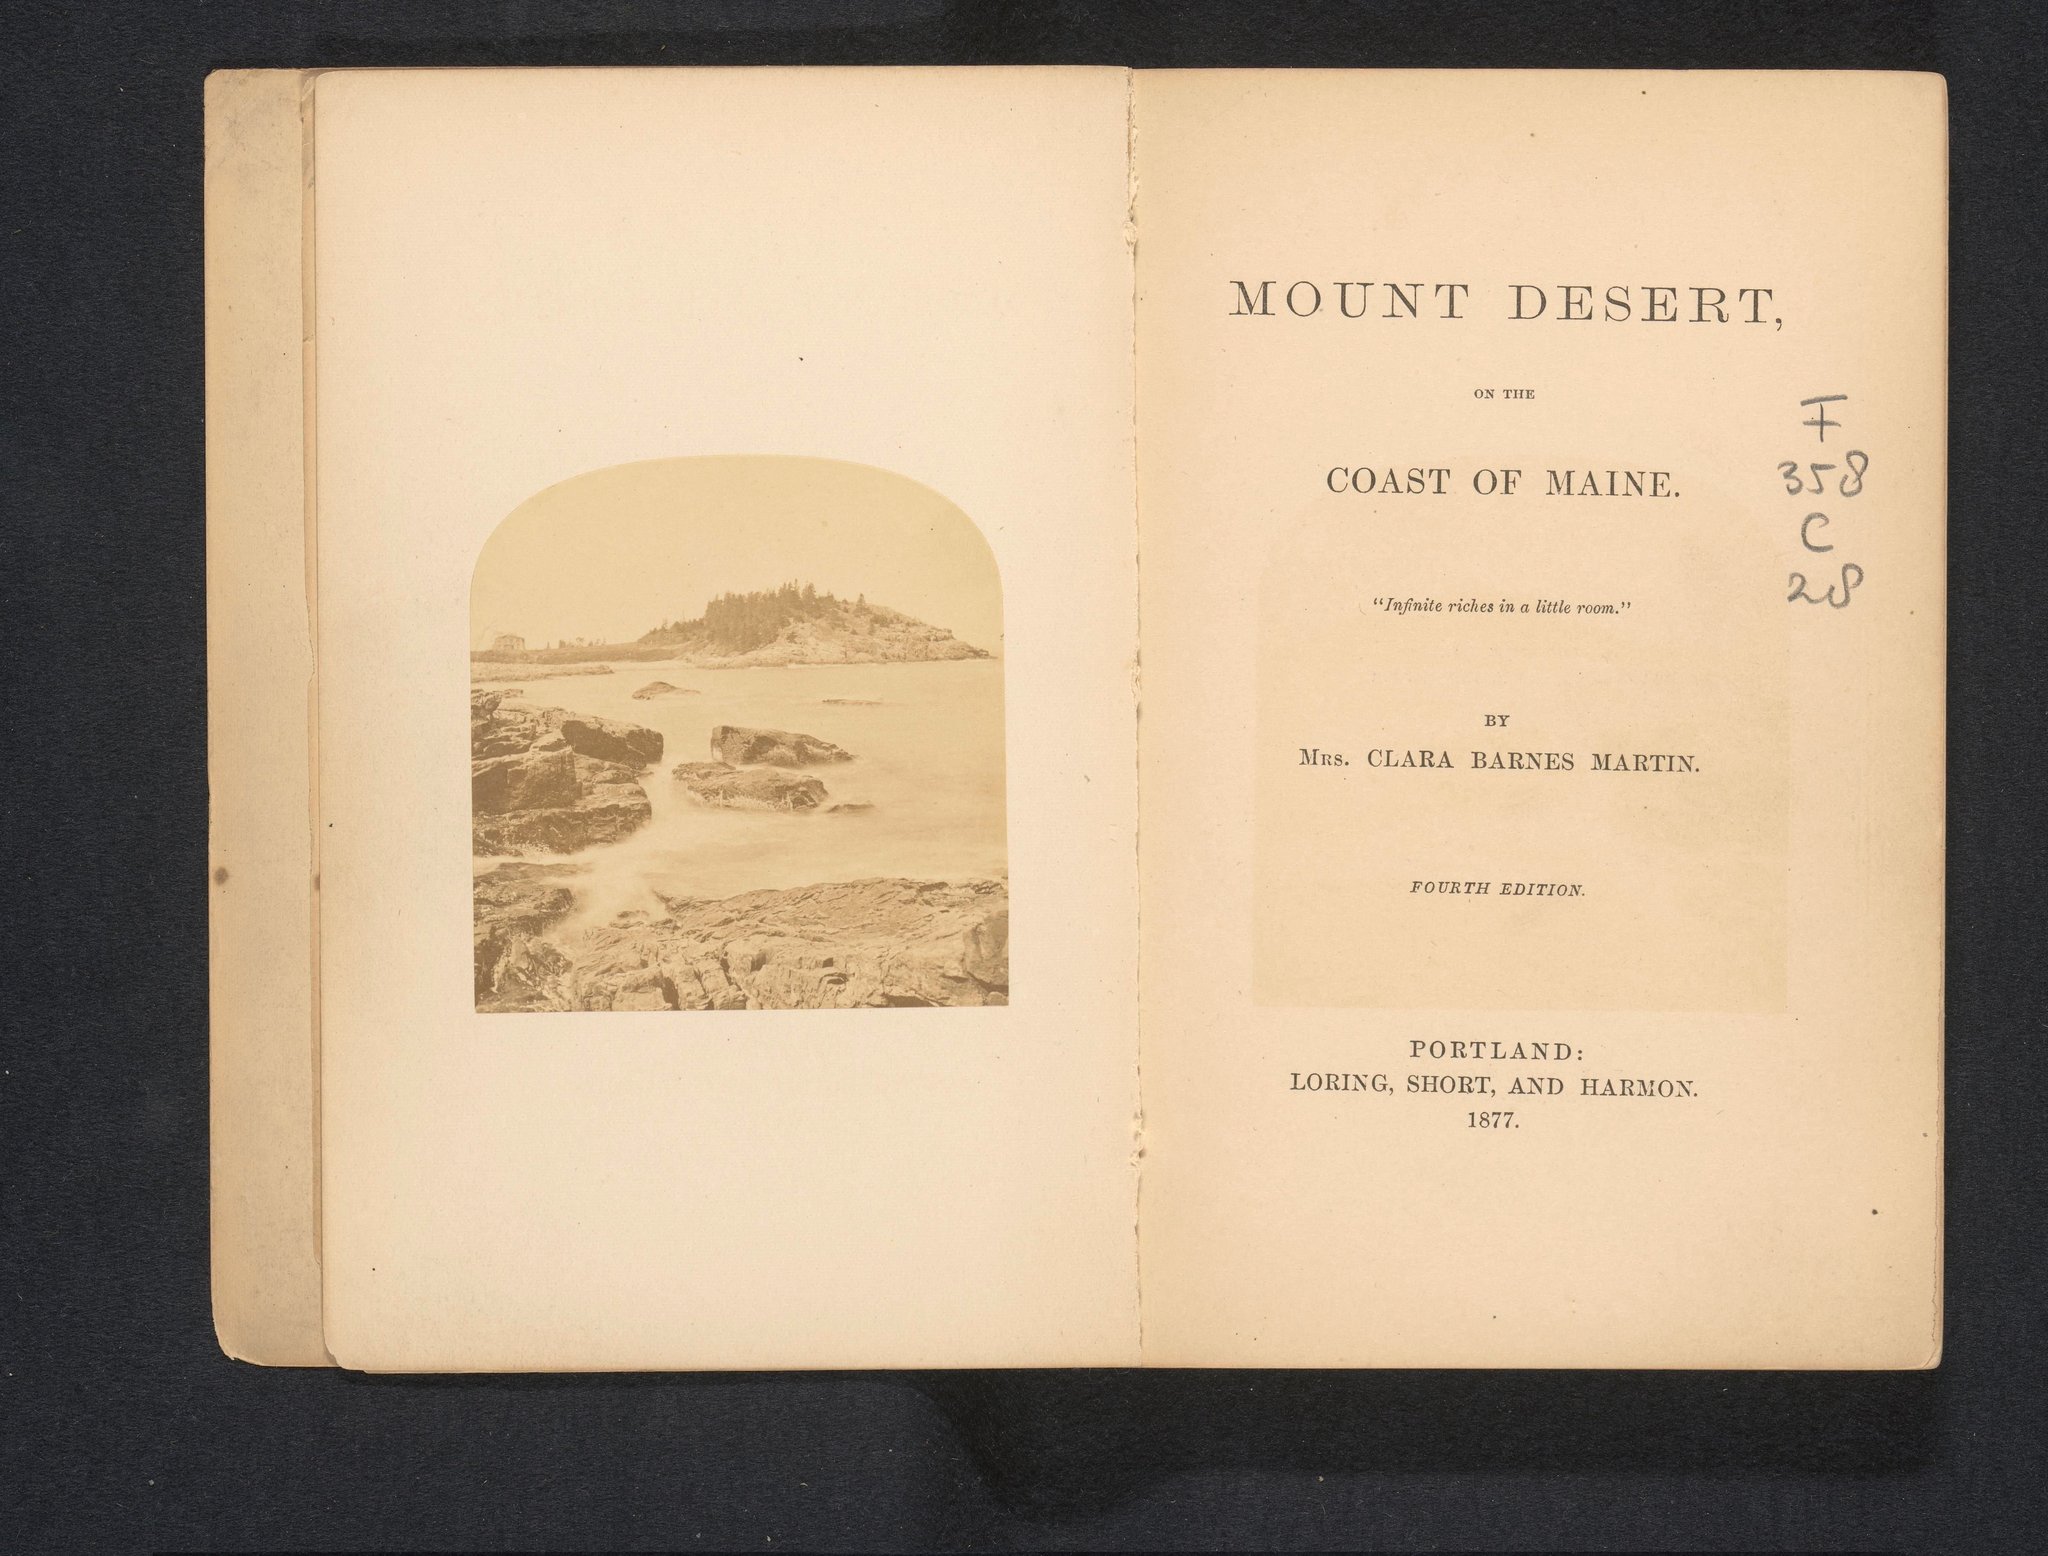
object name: book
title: Mount Desert on the coast of Maine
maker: clara barnes martin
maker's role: auteur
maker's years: -1886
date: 1877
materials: linen, paper, photographic support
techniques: albumen print, printing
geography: portland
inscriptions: date: ‘Feb 1994’, annotation: ‘H.S. [...]/ August 22 7 78’